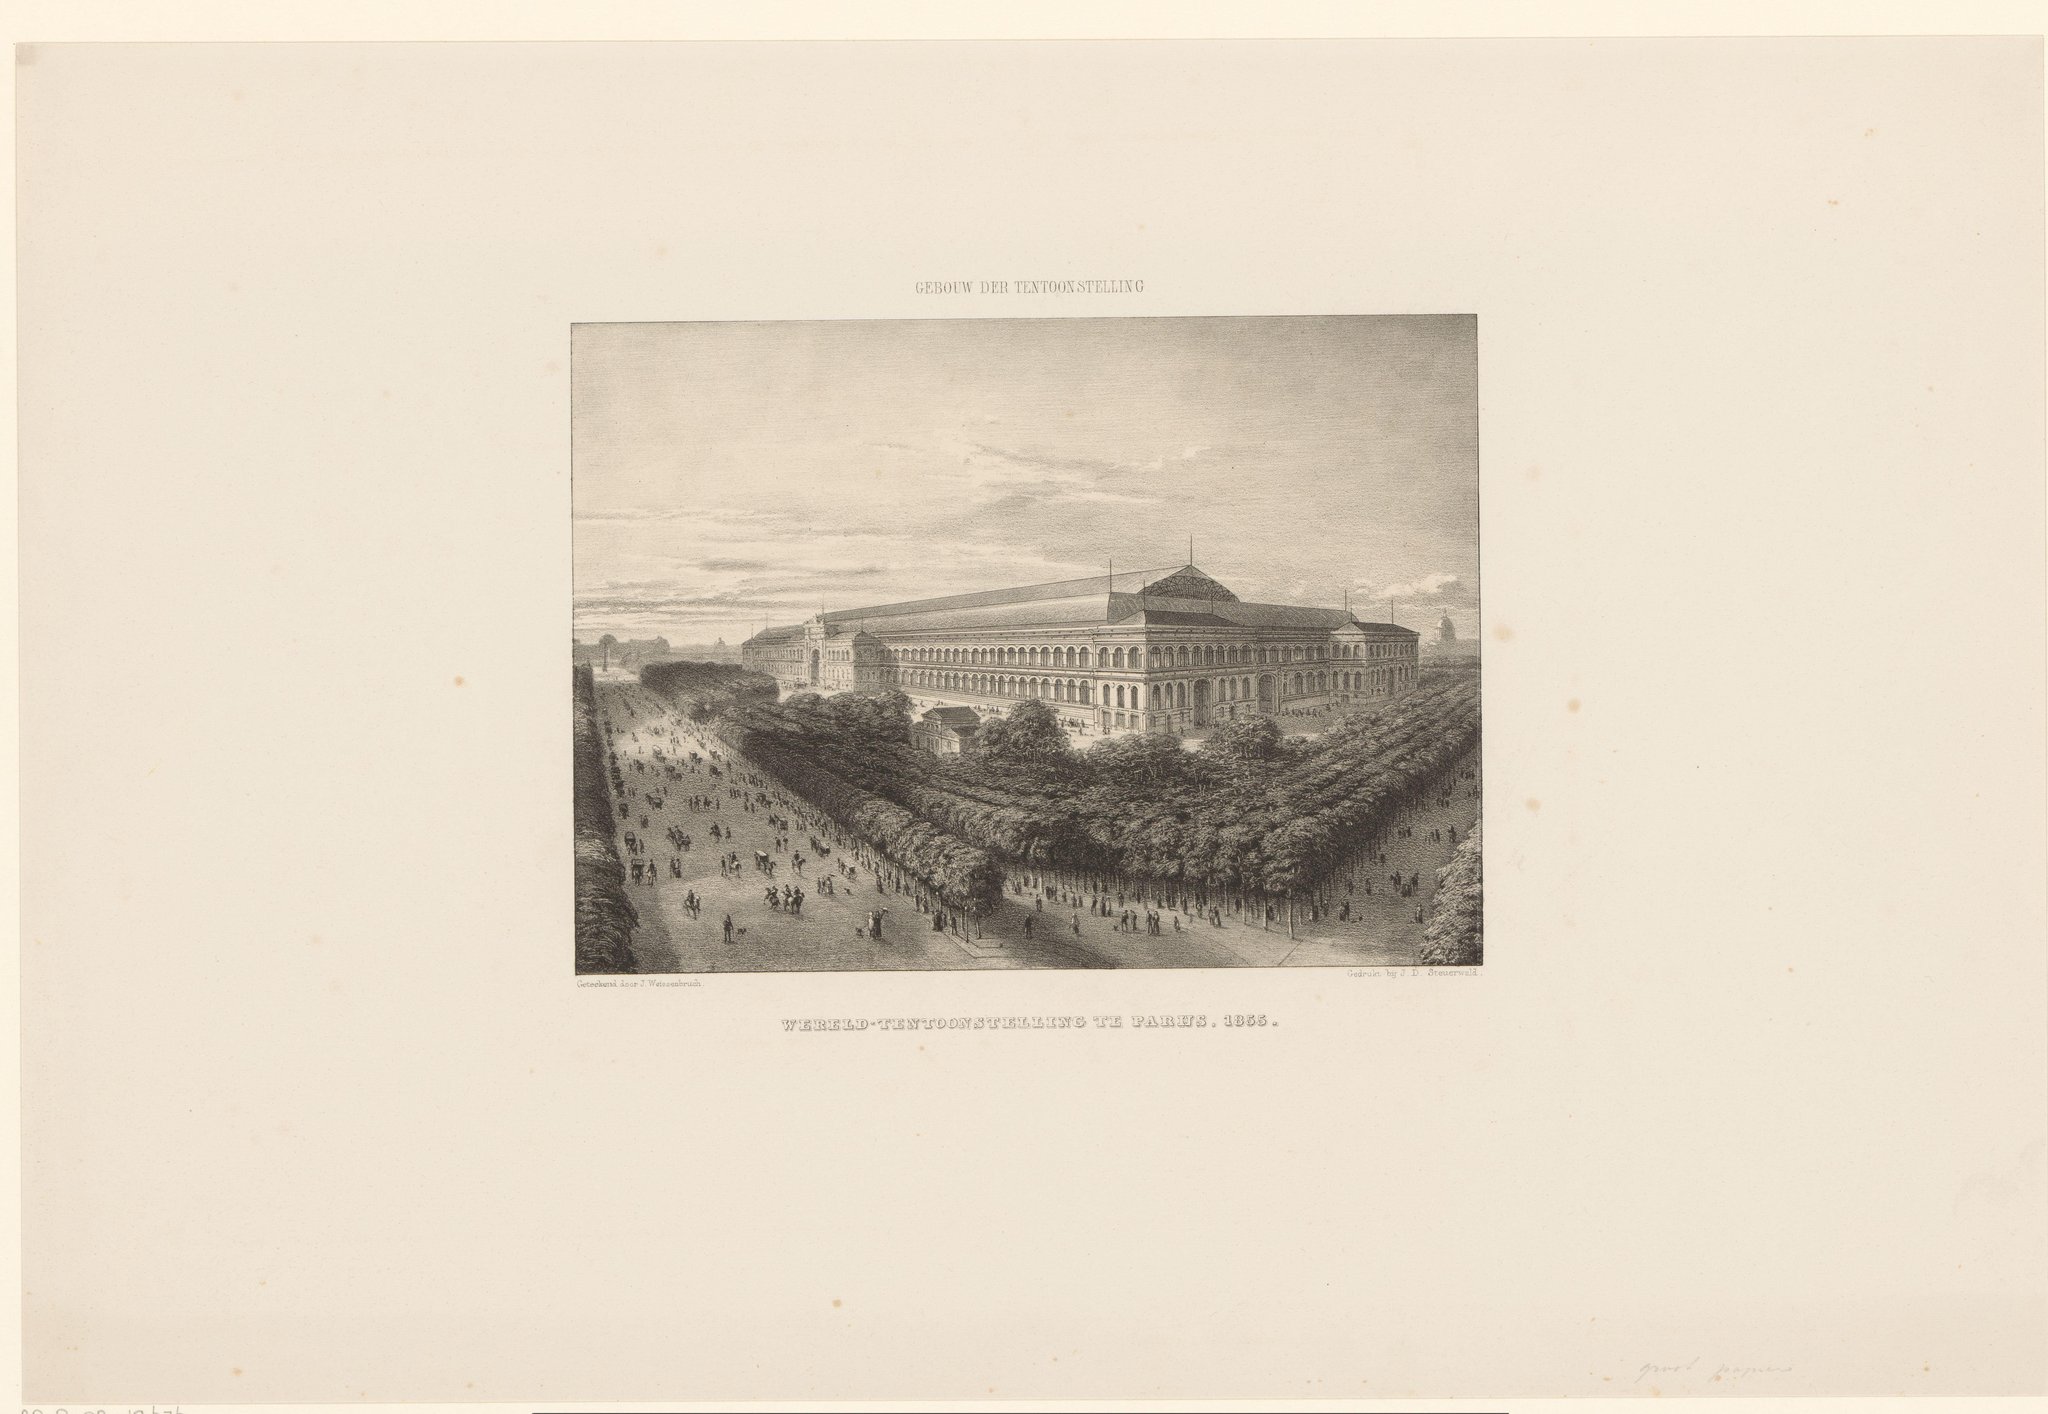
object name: print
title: Wereld-tentoonstelling te Parijs, 1855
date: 1856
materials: paper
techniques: lithograph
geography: the hague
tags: world fair, world exhibition, paris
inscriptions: collector's mark: Lugt 2228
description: Gezicht op Palais de l'Industrie, gebouwd voor de wereldtentoonstelling in 1855.